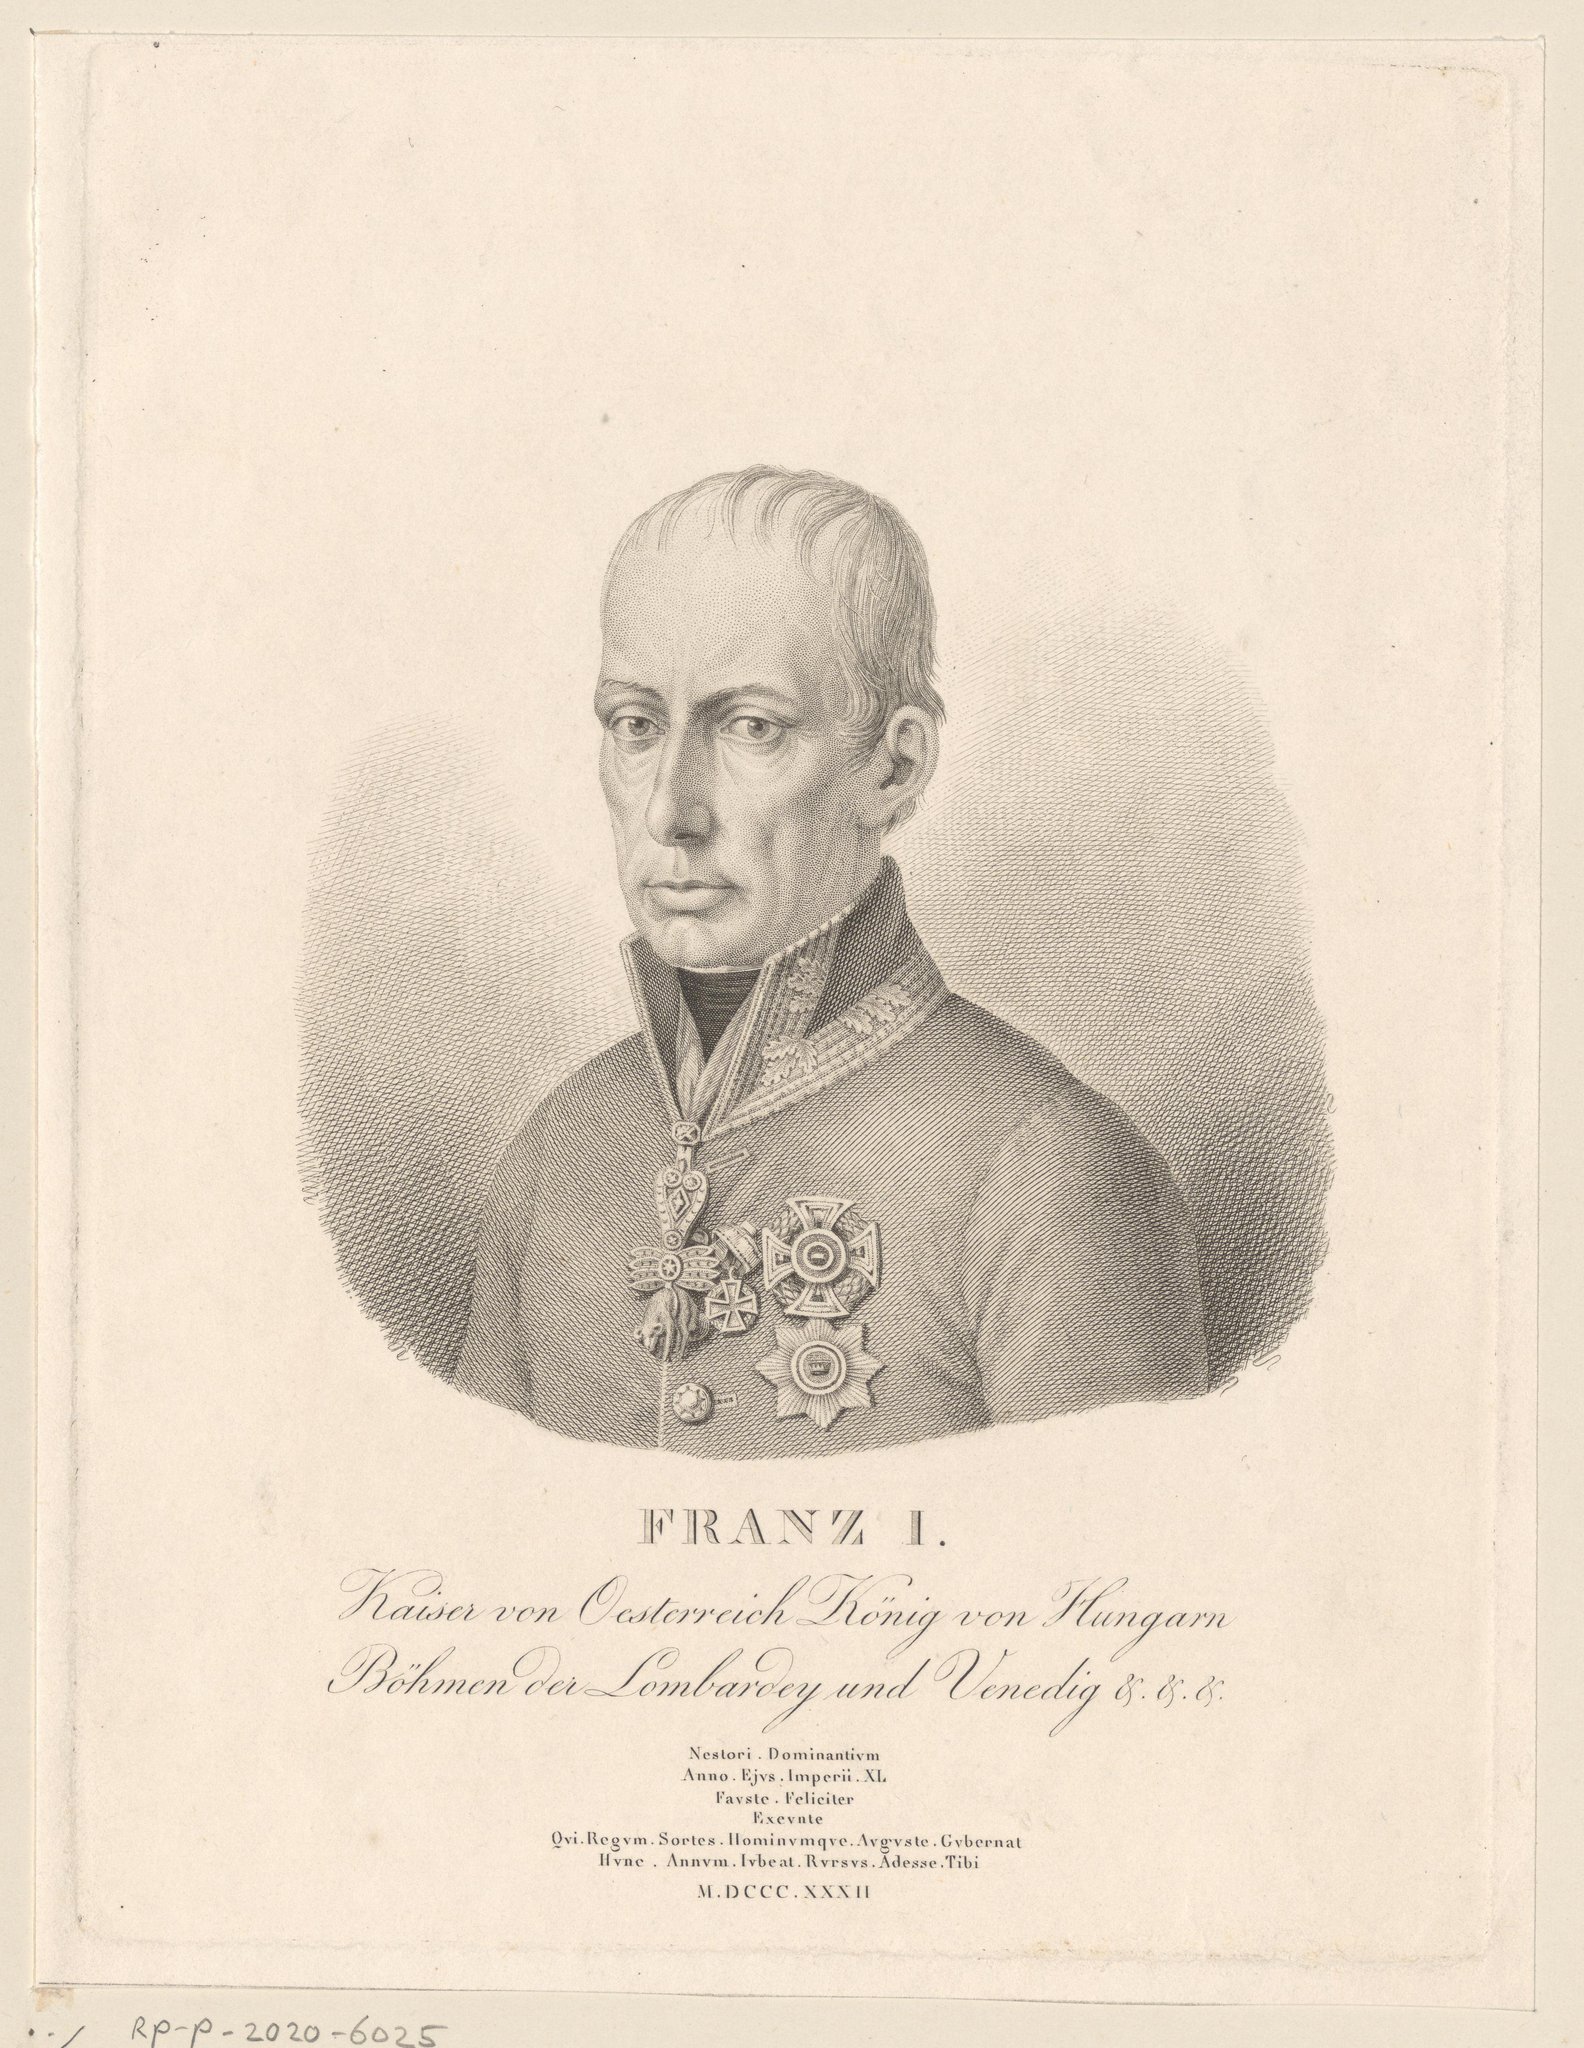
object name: print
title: Portret van Frans I, keizer van Oostenrijk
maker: Anonymous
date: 1832-1850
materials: paper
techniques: engraving, etching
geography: austria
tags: vienna, frans ii (rooms-duits keizer), historical persons, knighthood order of the golden fleece, emperor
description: Met onderschrift in het Duits en Latijn.